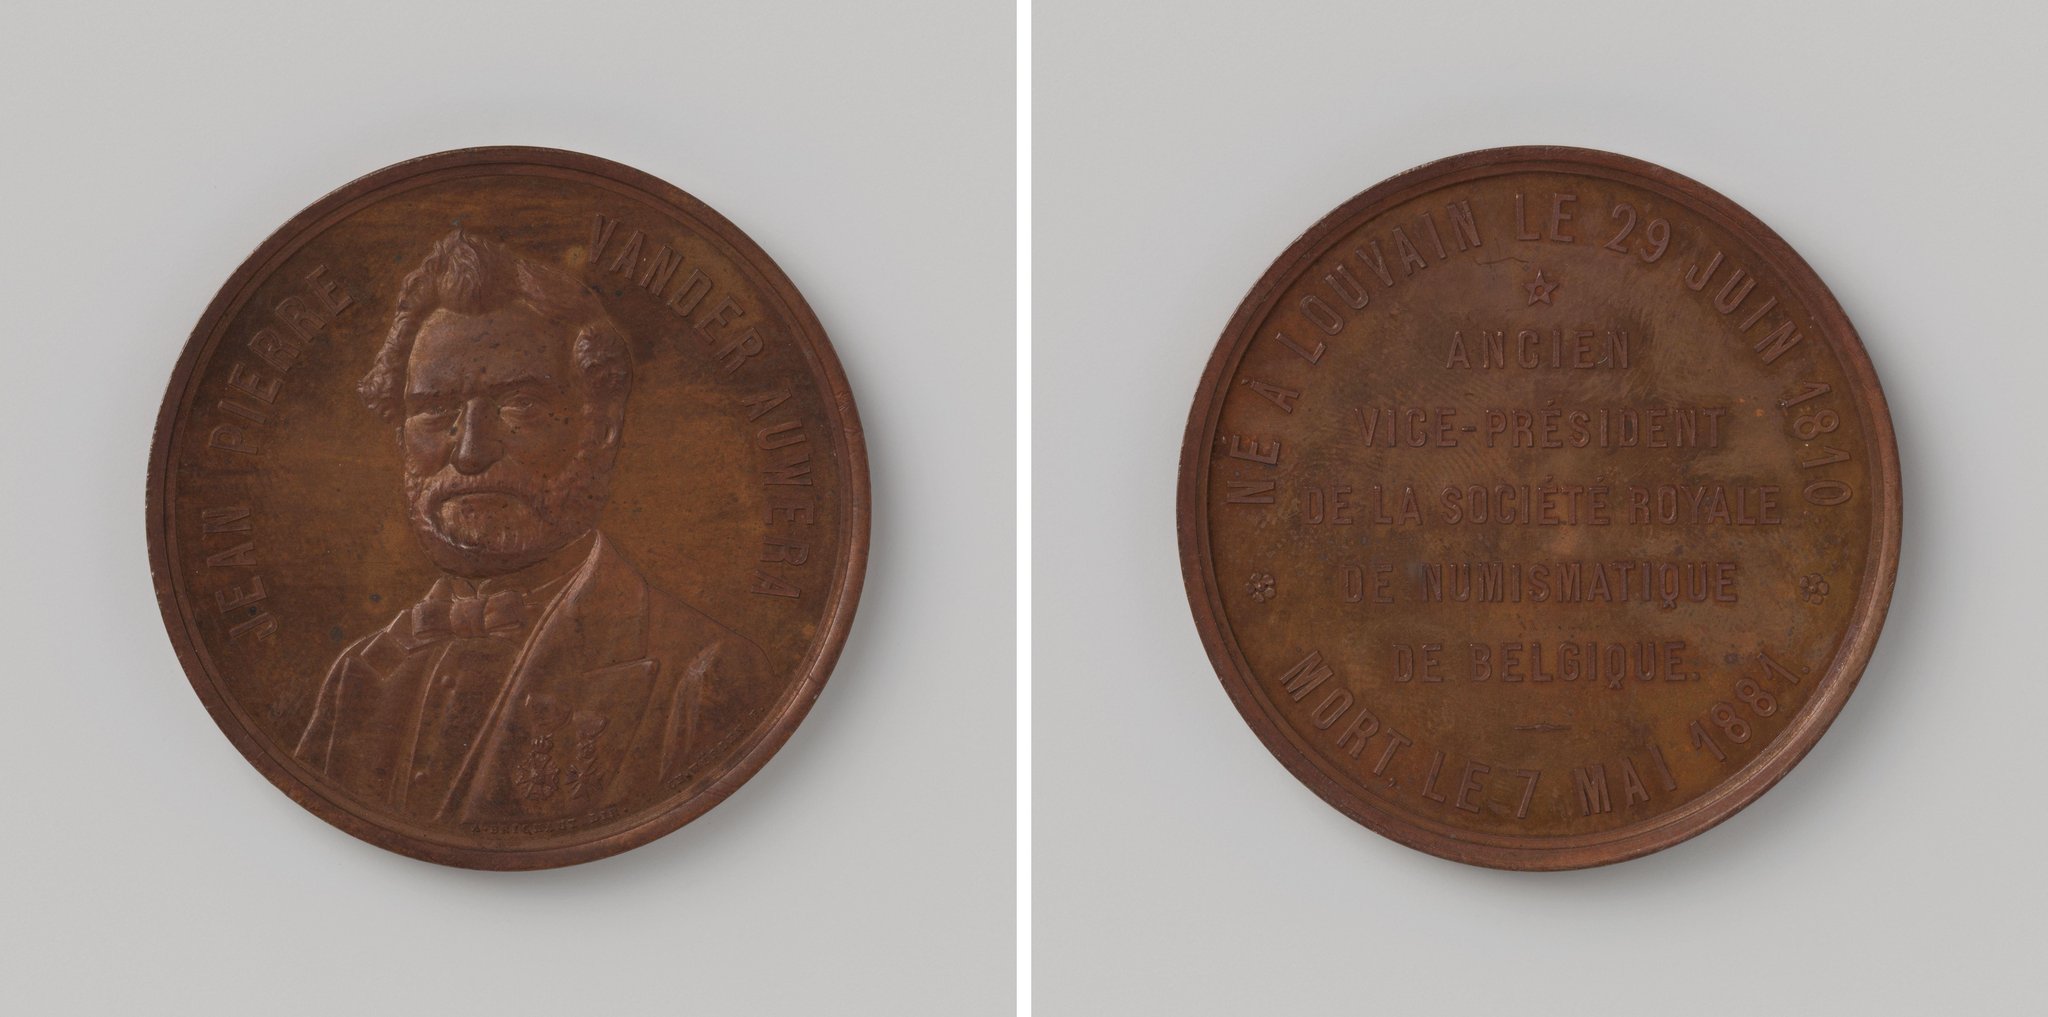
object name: history medal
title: Overlijden van Jean Pierre van der Auwera, gewezen vice-voorzitter van de Societe Royale de Numismatique de Belgique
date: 1881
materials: bronze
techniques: striking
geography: brussels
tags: belgium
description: Bronzen penning. Voorzijde: borststuk man binnen omschrift. Keerzijde: opschrift binnen omschrift.